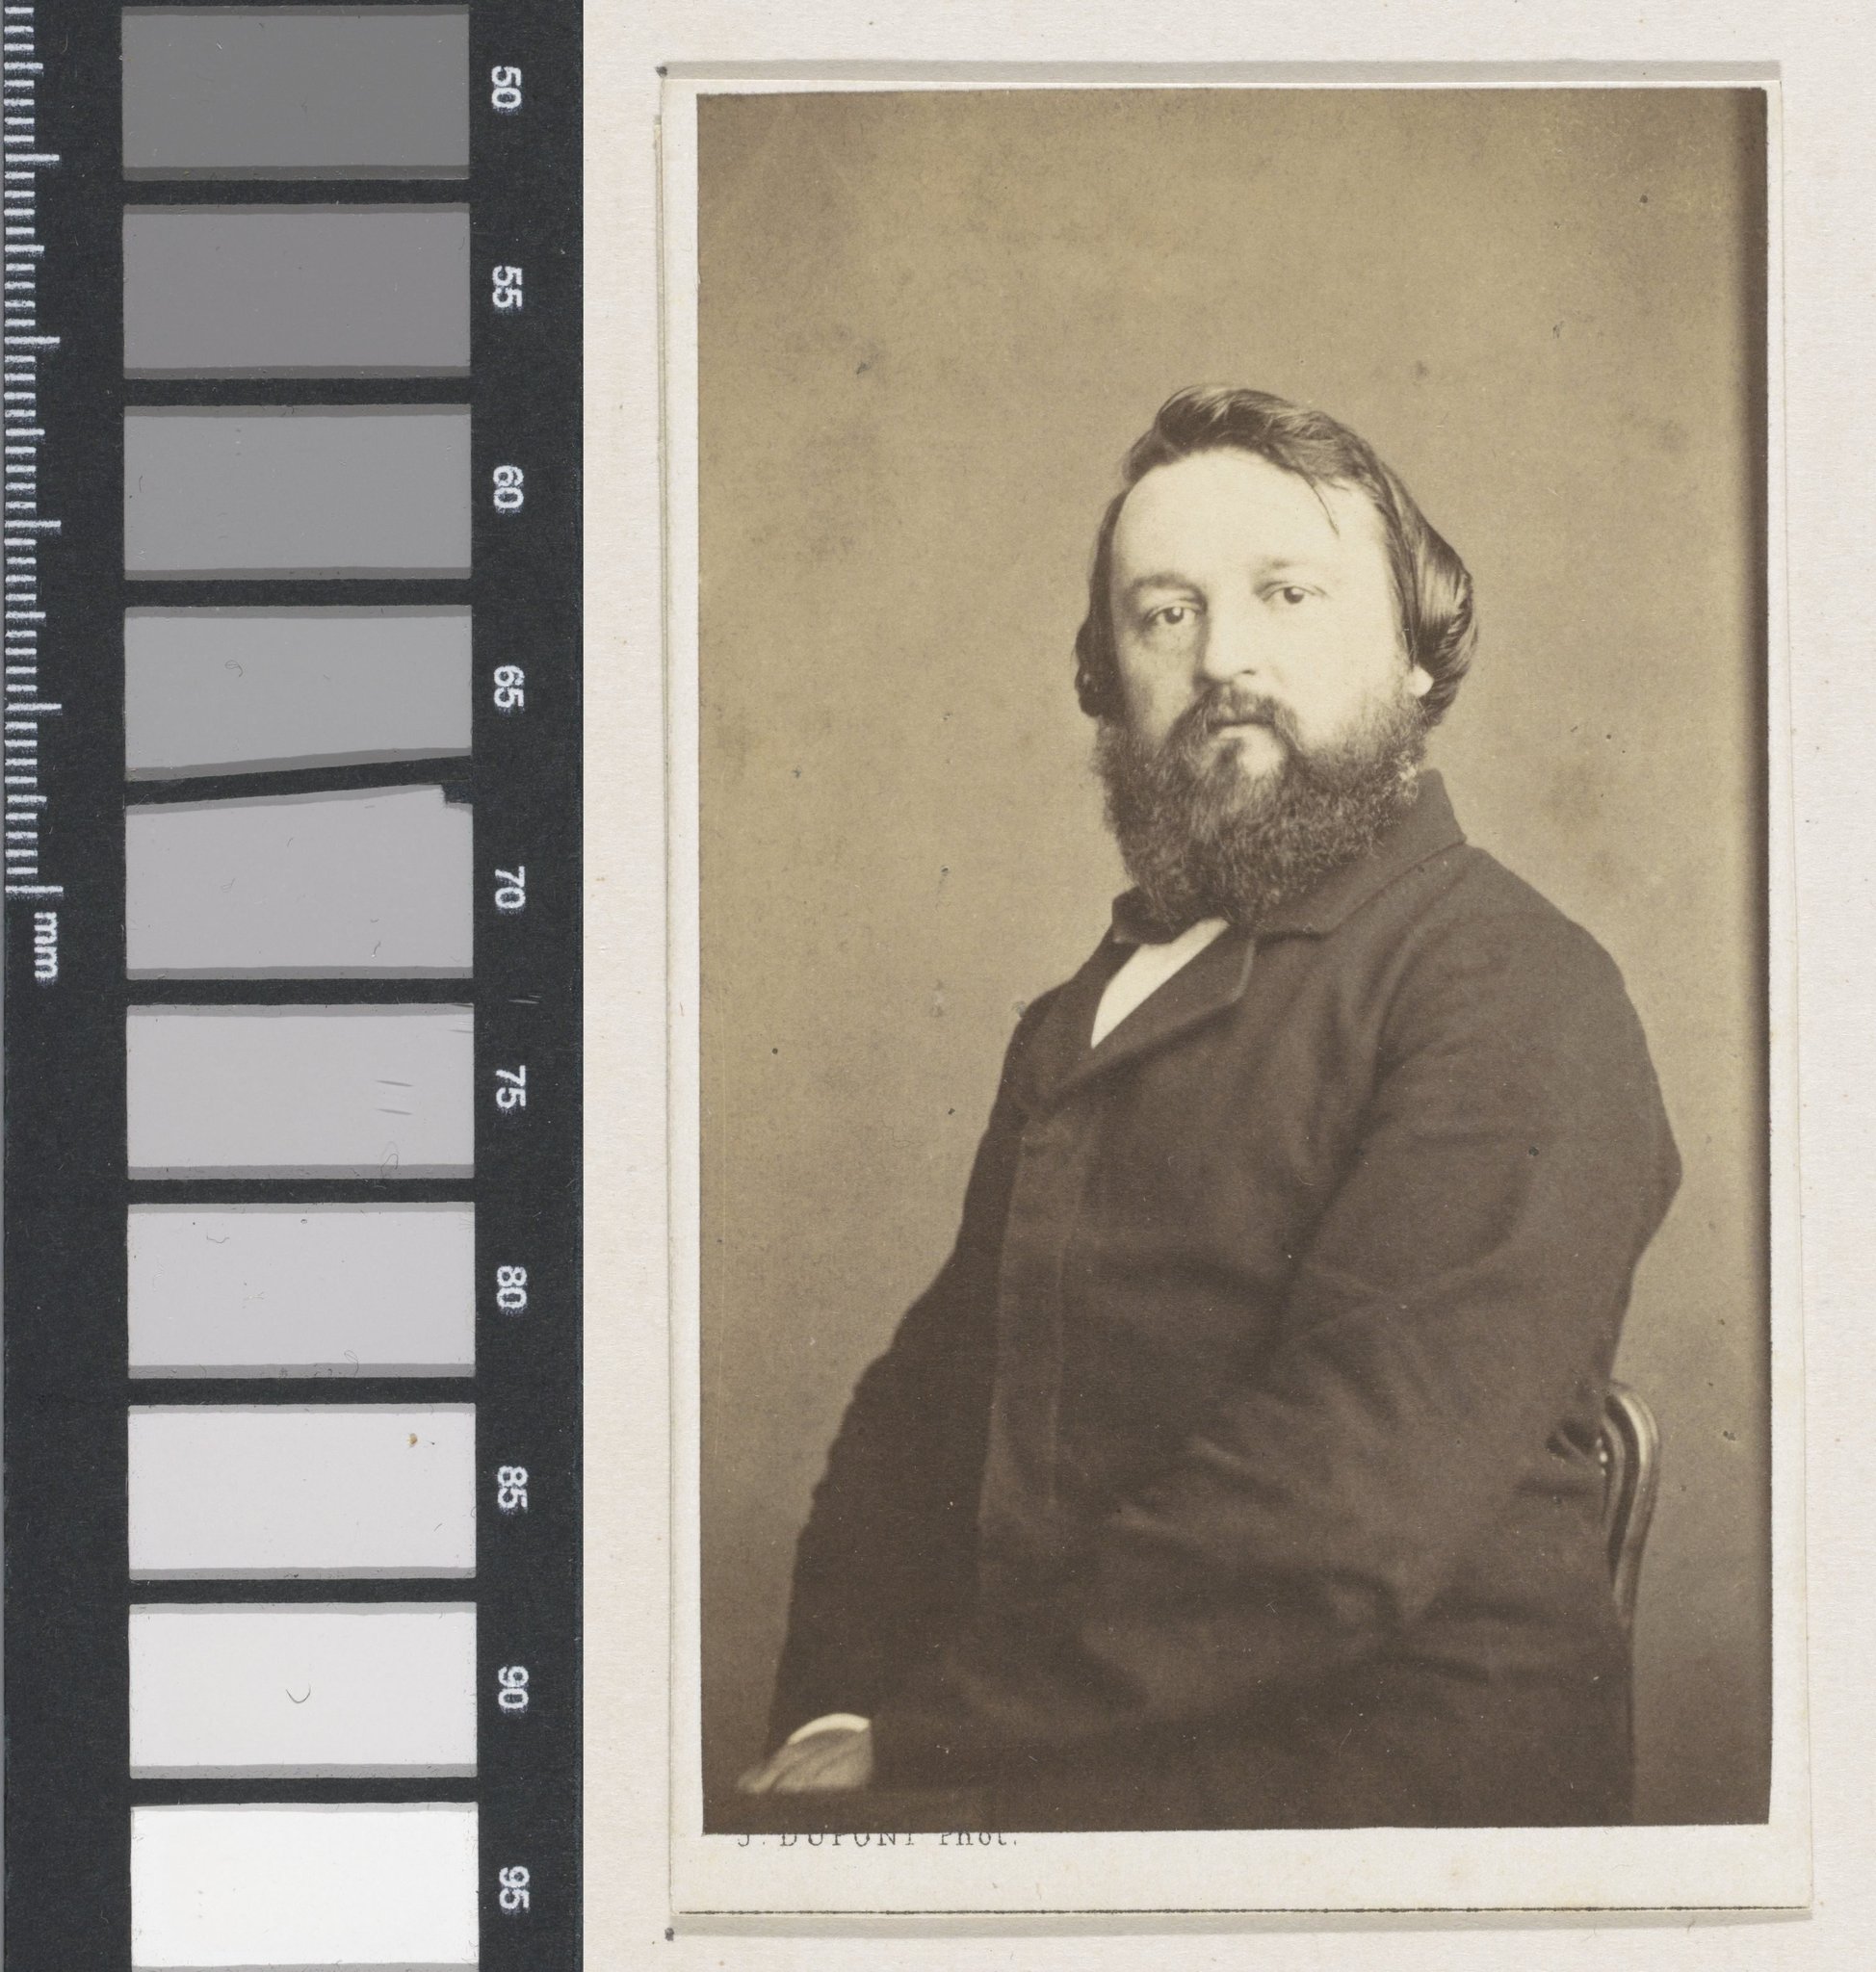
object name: photograph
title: Portret van de beeldhouwer Sopers, halffiguur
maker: joseph dupont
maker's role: fotograaf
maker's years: 1818-1901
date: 1861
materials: cardboard, paper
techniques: albumen print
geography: antwerp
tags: den bosch, sculptor, portrait, self-portrait of sculptor, historical persons, portrait, self-portrait of artist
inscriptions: signature: ‘ETABLISSEMENT PHOTOGRAPHIQUE/ de/ J. DUPONT/ Place de Meir 32/ ANVERS/ Maison fondée en 1853’